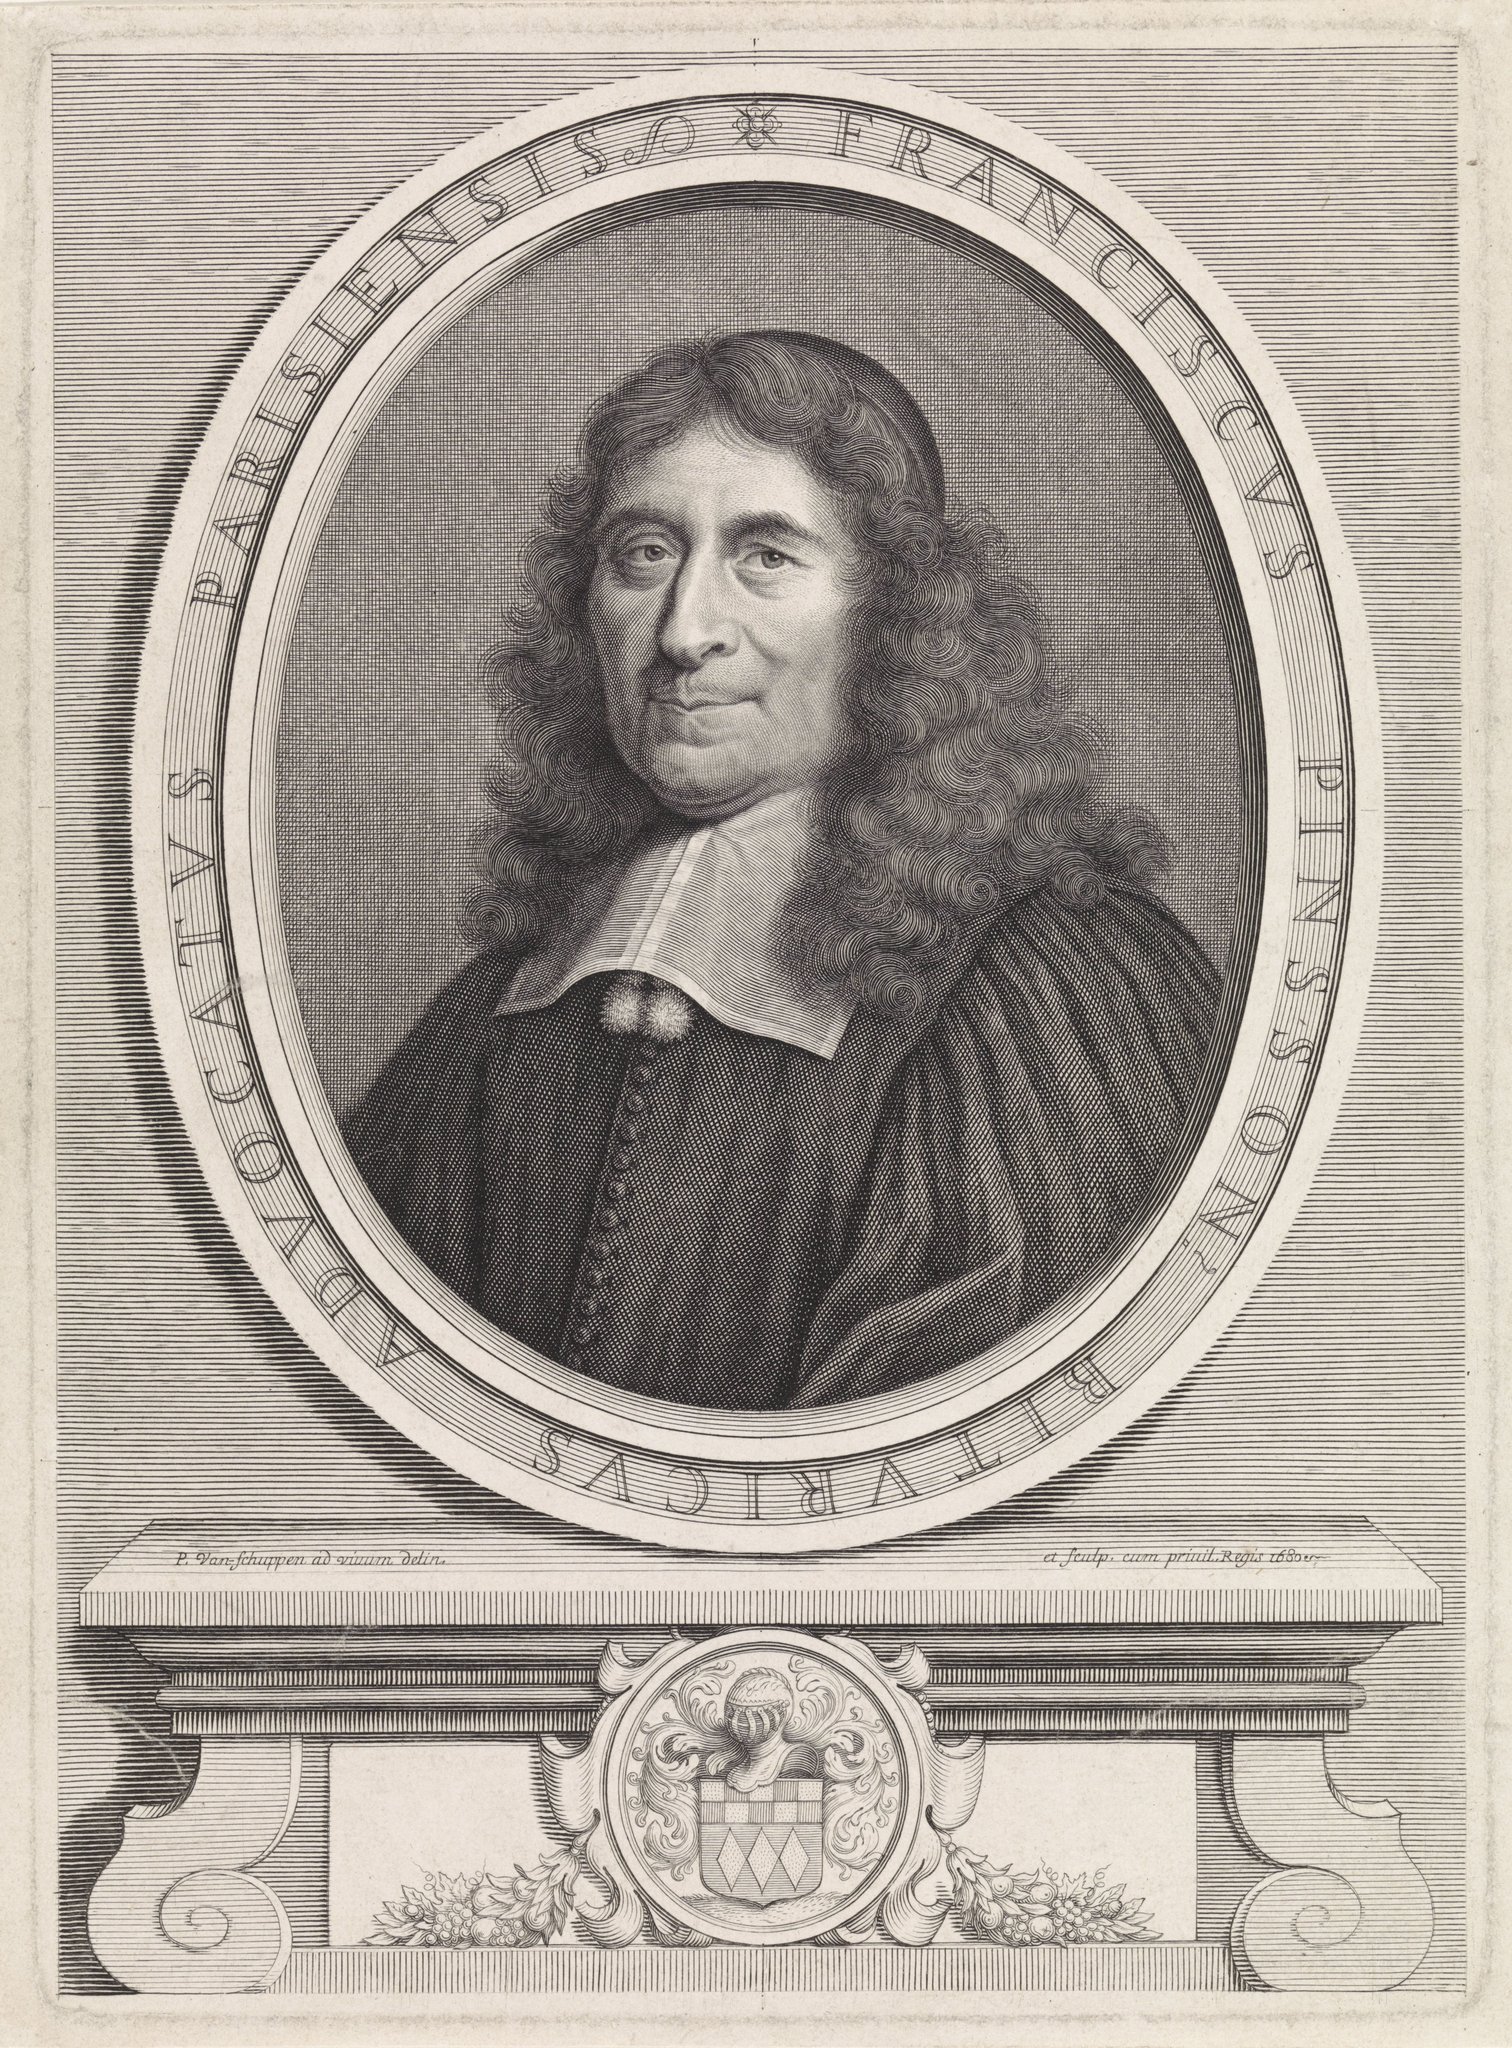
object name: print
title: Portret van de jurist François Pinsson DesRiolles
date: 1605-1680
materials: paper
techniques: engraving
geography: paris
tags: schrijver, jurist, françois pinsson desriolles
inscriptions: collector's mark: Lugt 2228